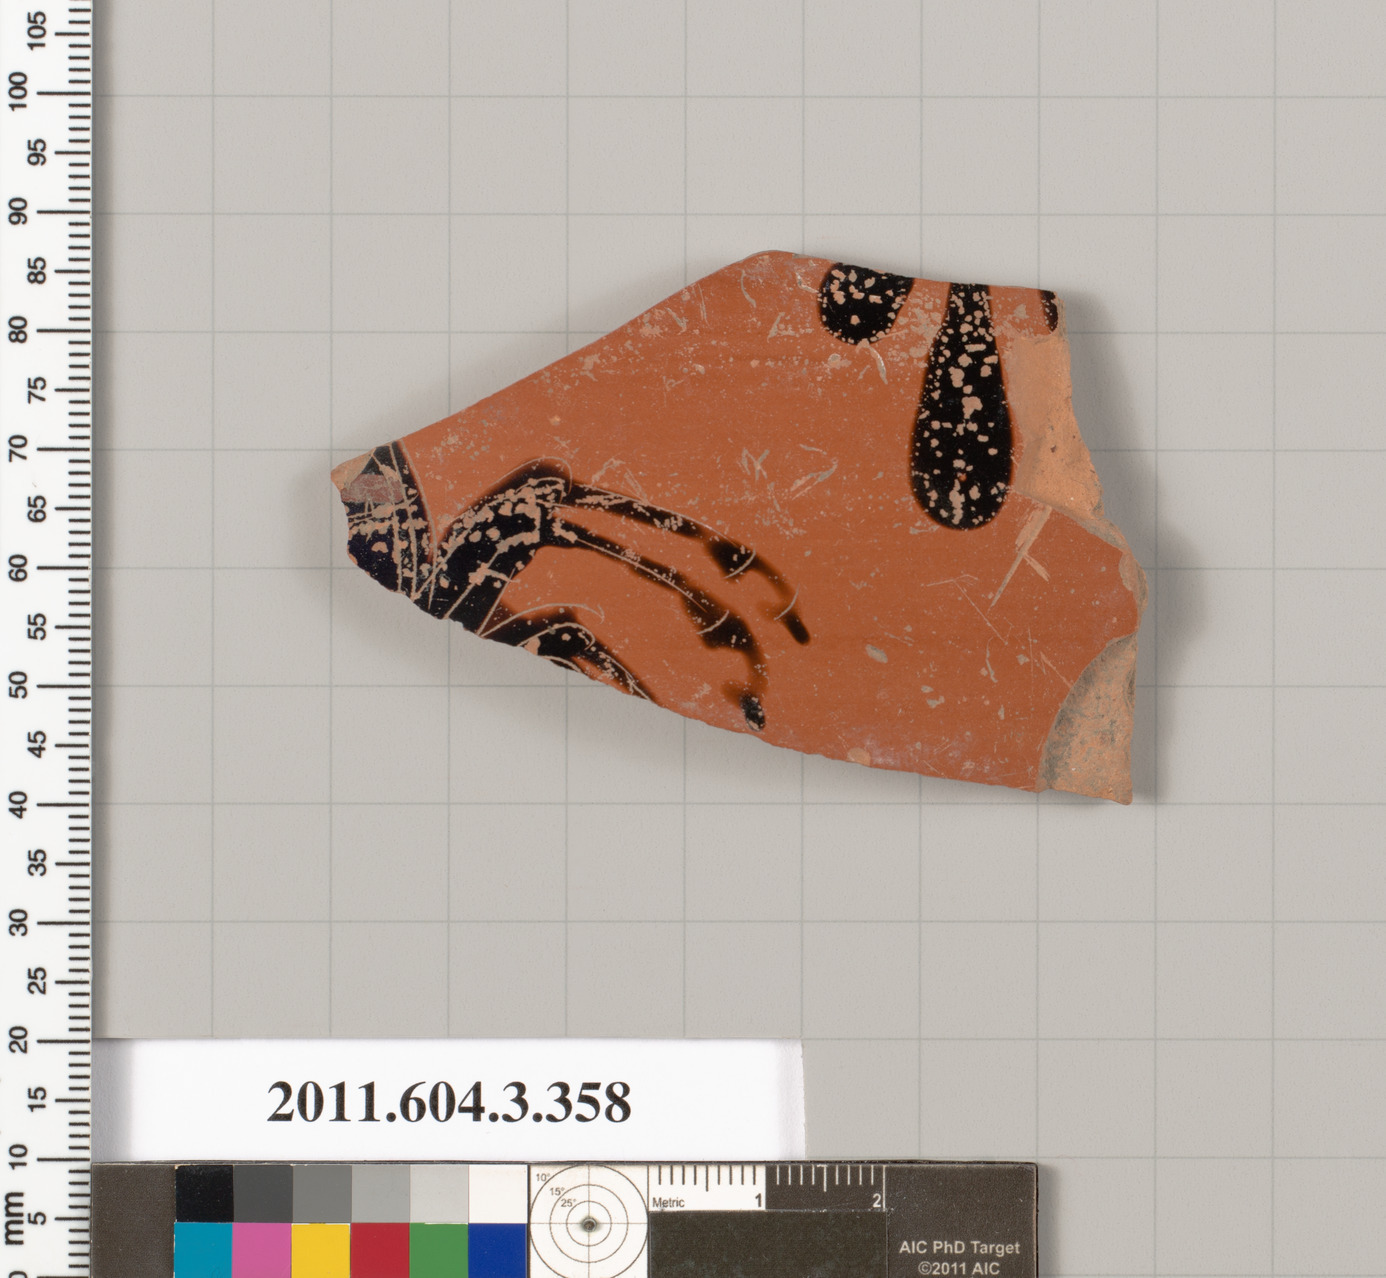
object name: neck amphora fragment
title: Terracotta fragment of a neck-amphora (jar)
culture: greek, attic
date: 534-501 BCE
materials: terracotta